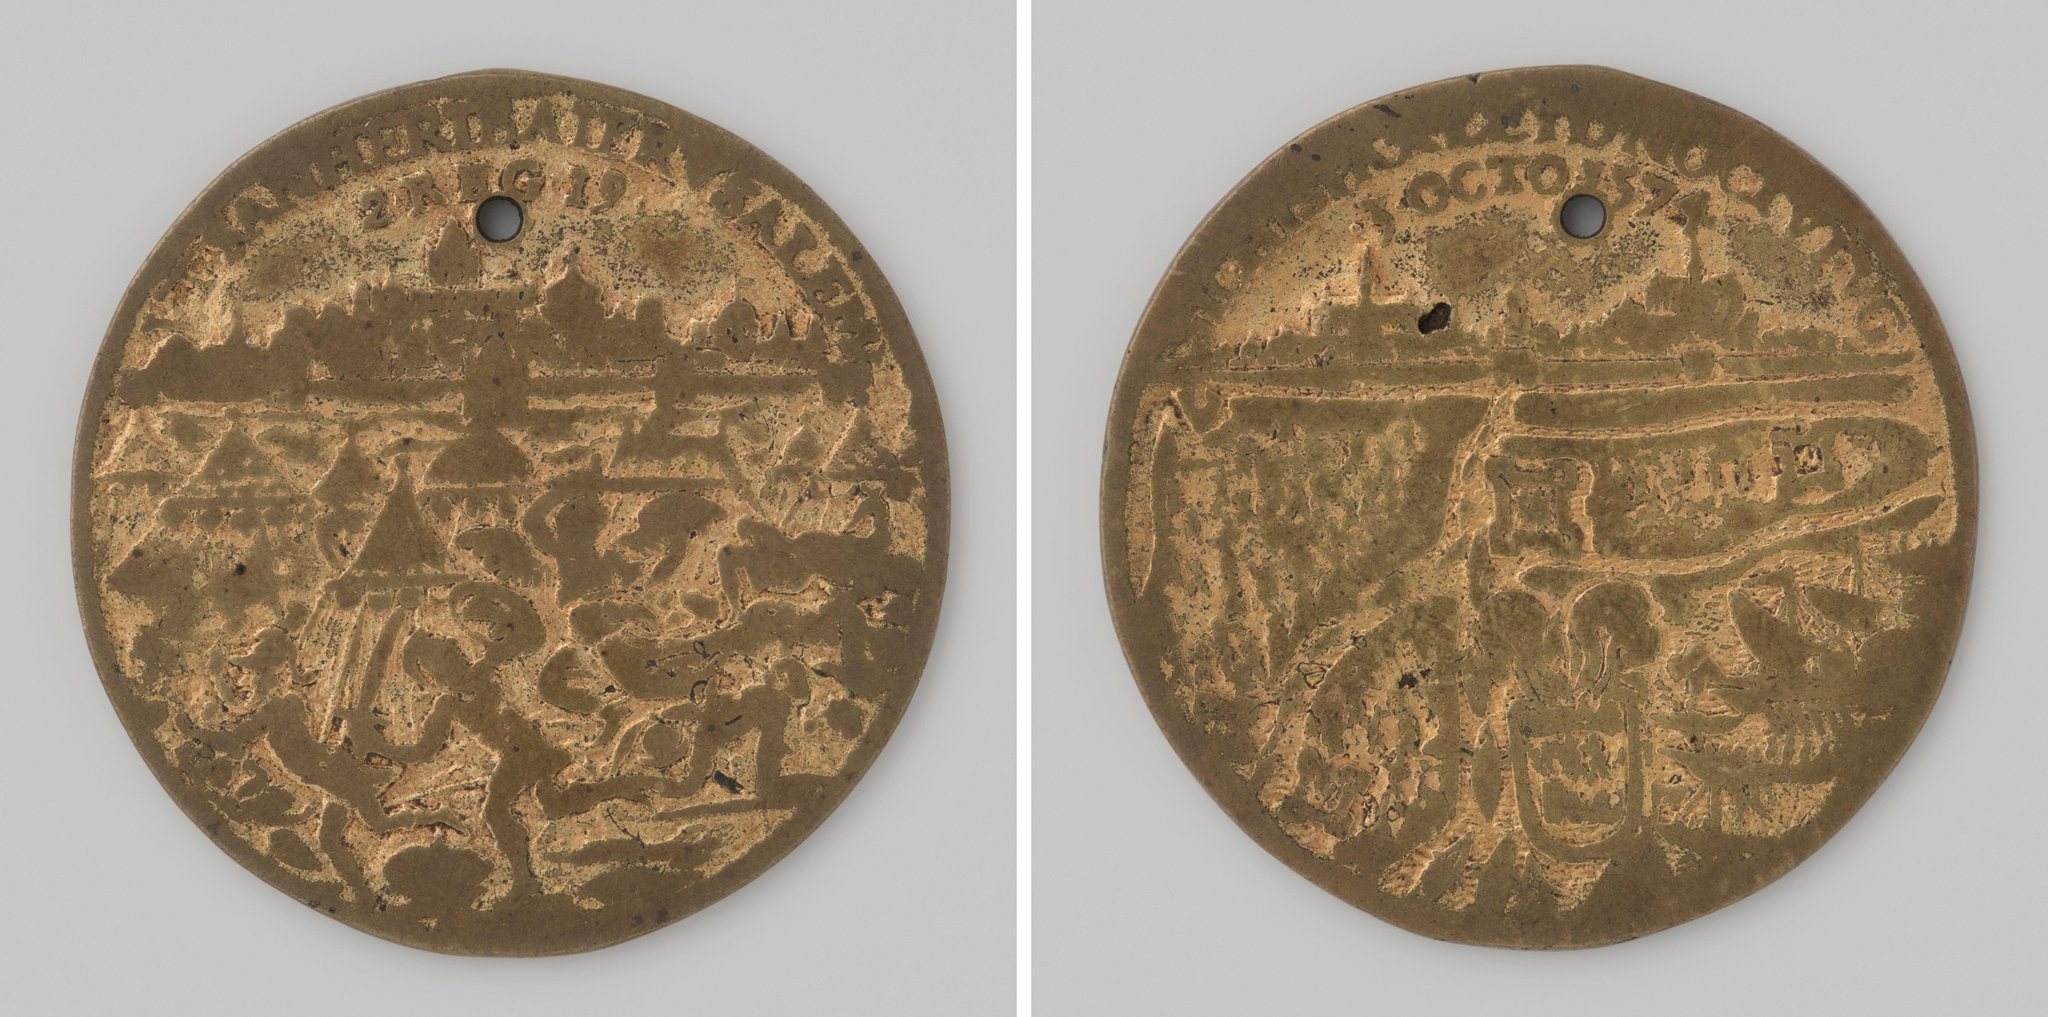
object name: history medal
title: Ontzet van Leiden 1574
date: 1574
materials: brass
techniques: casting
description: Verguld messing penning, op de voorzijde het leger van Sanherib voor Jerusalem door een engel verdreven, met omschrift, op de keerzijde aanzicht en plattegrond van Leiden waar Spanjaarden hun schansen verlaten, met draaggat